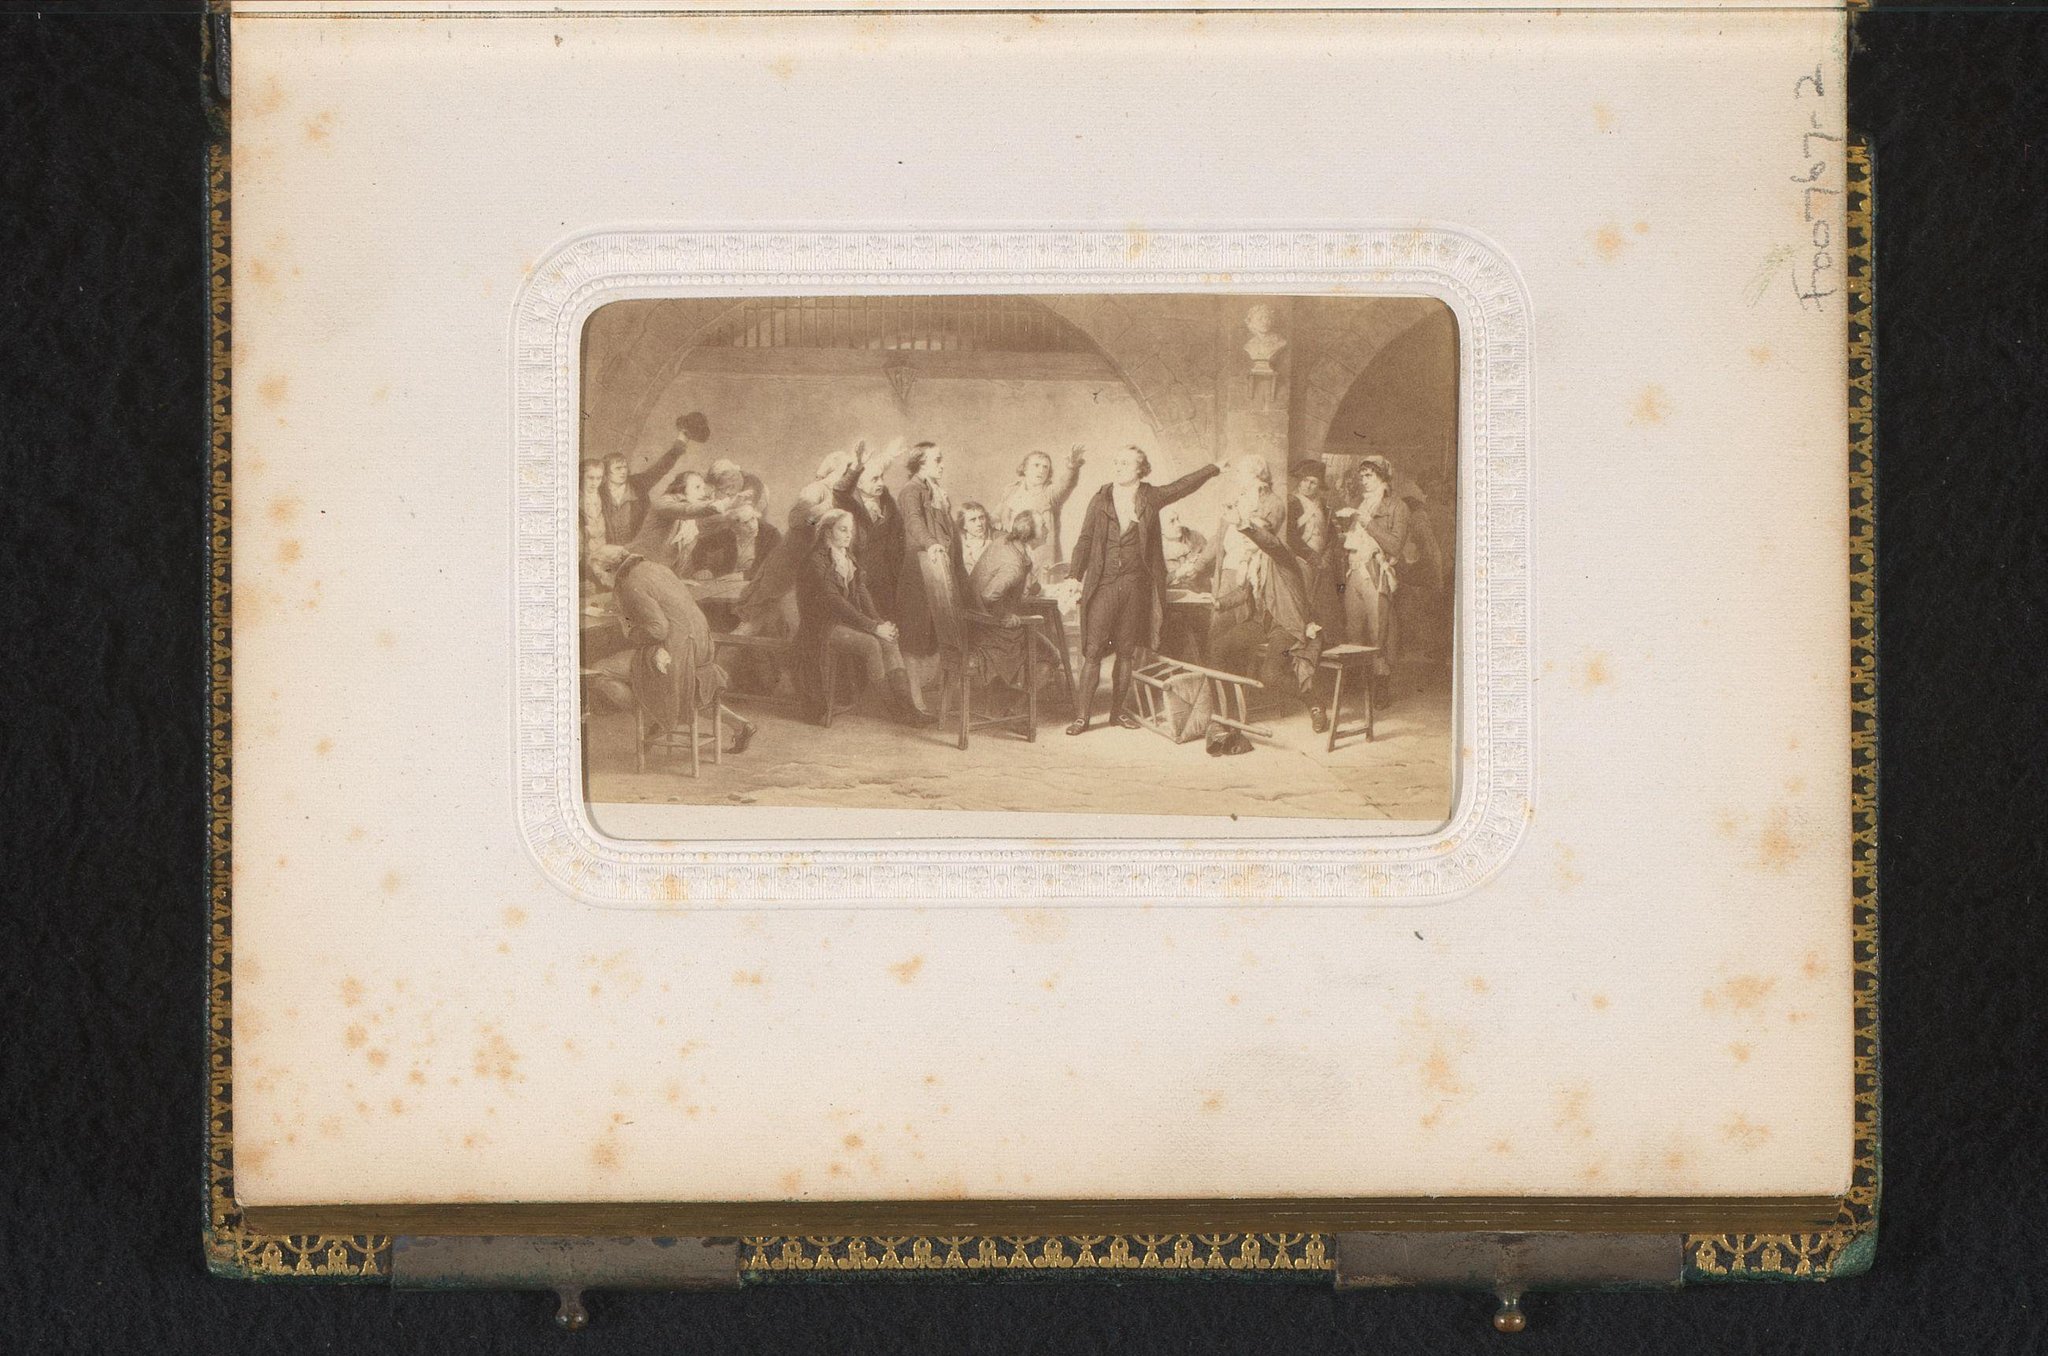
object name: carte de visite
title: Fotoreproductie van een schilderij van een bijeenkomst van girondijnen door Paul Delaroche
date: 1861-1878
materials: cardboard, photographic support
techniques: albumen print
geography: paris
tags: meeting, assembly, france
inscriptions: inscription: ‘PHOTOGRAPHIE GOUPIL & Cie/ PARIS, 19, Bd Montmartre./ LONDRES-LA HAYE-BERLIN-NEW YORK’